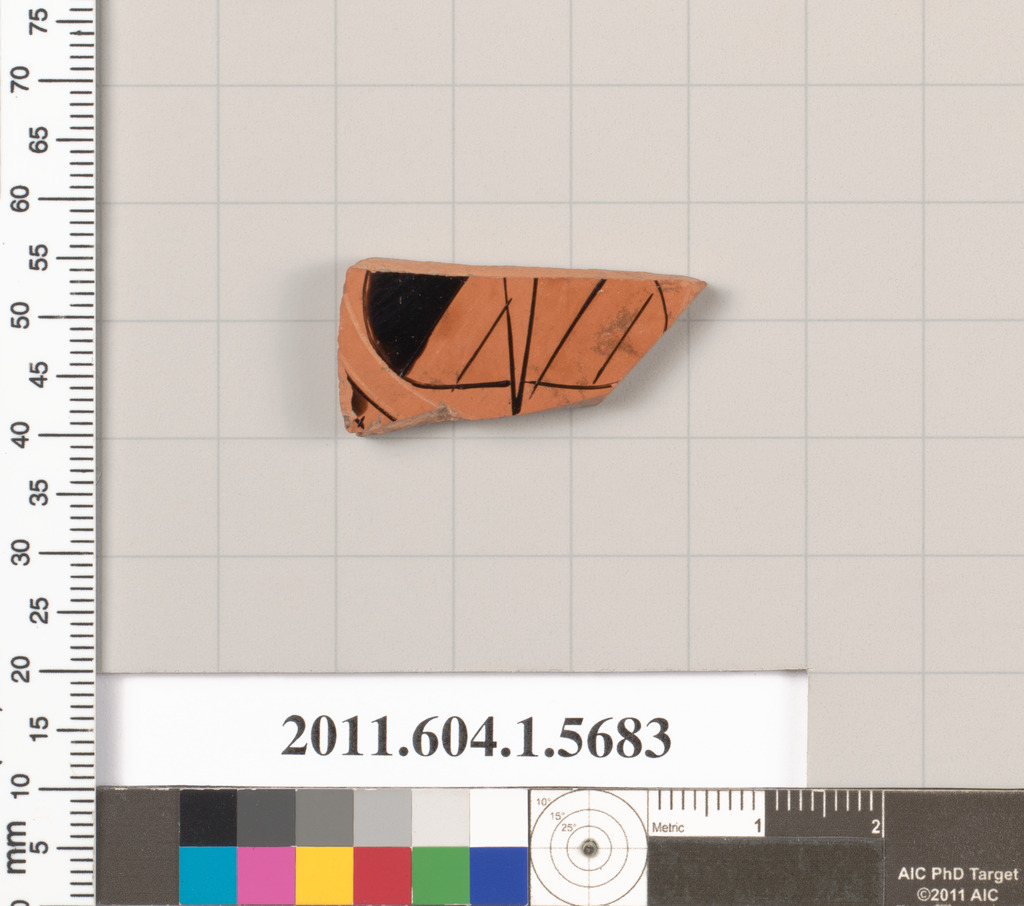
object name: kylix fragment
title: Terracotta fragment of a kylix (drinking cup)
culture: greek, attic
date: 500-480 BCE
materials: terracotta